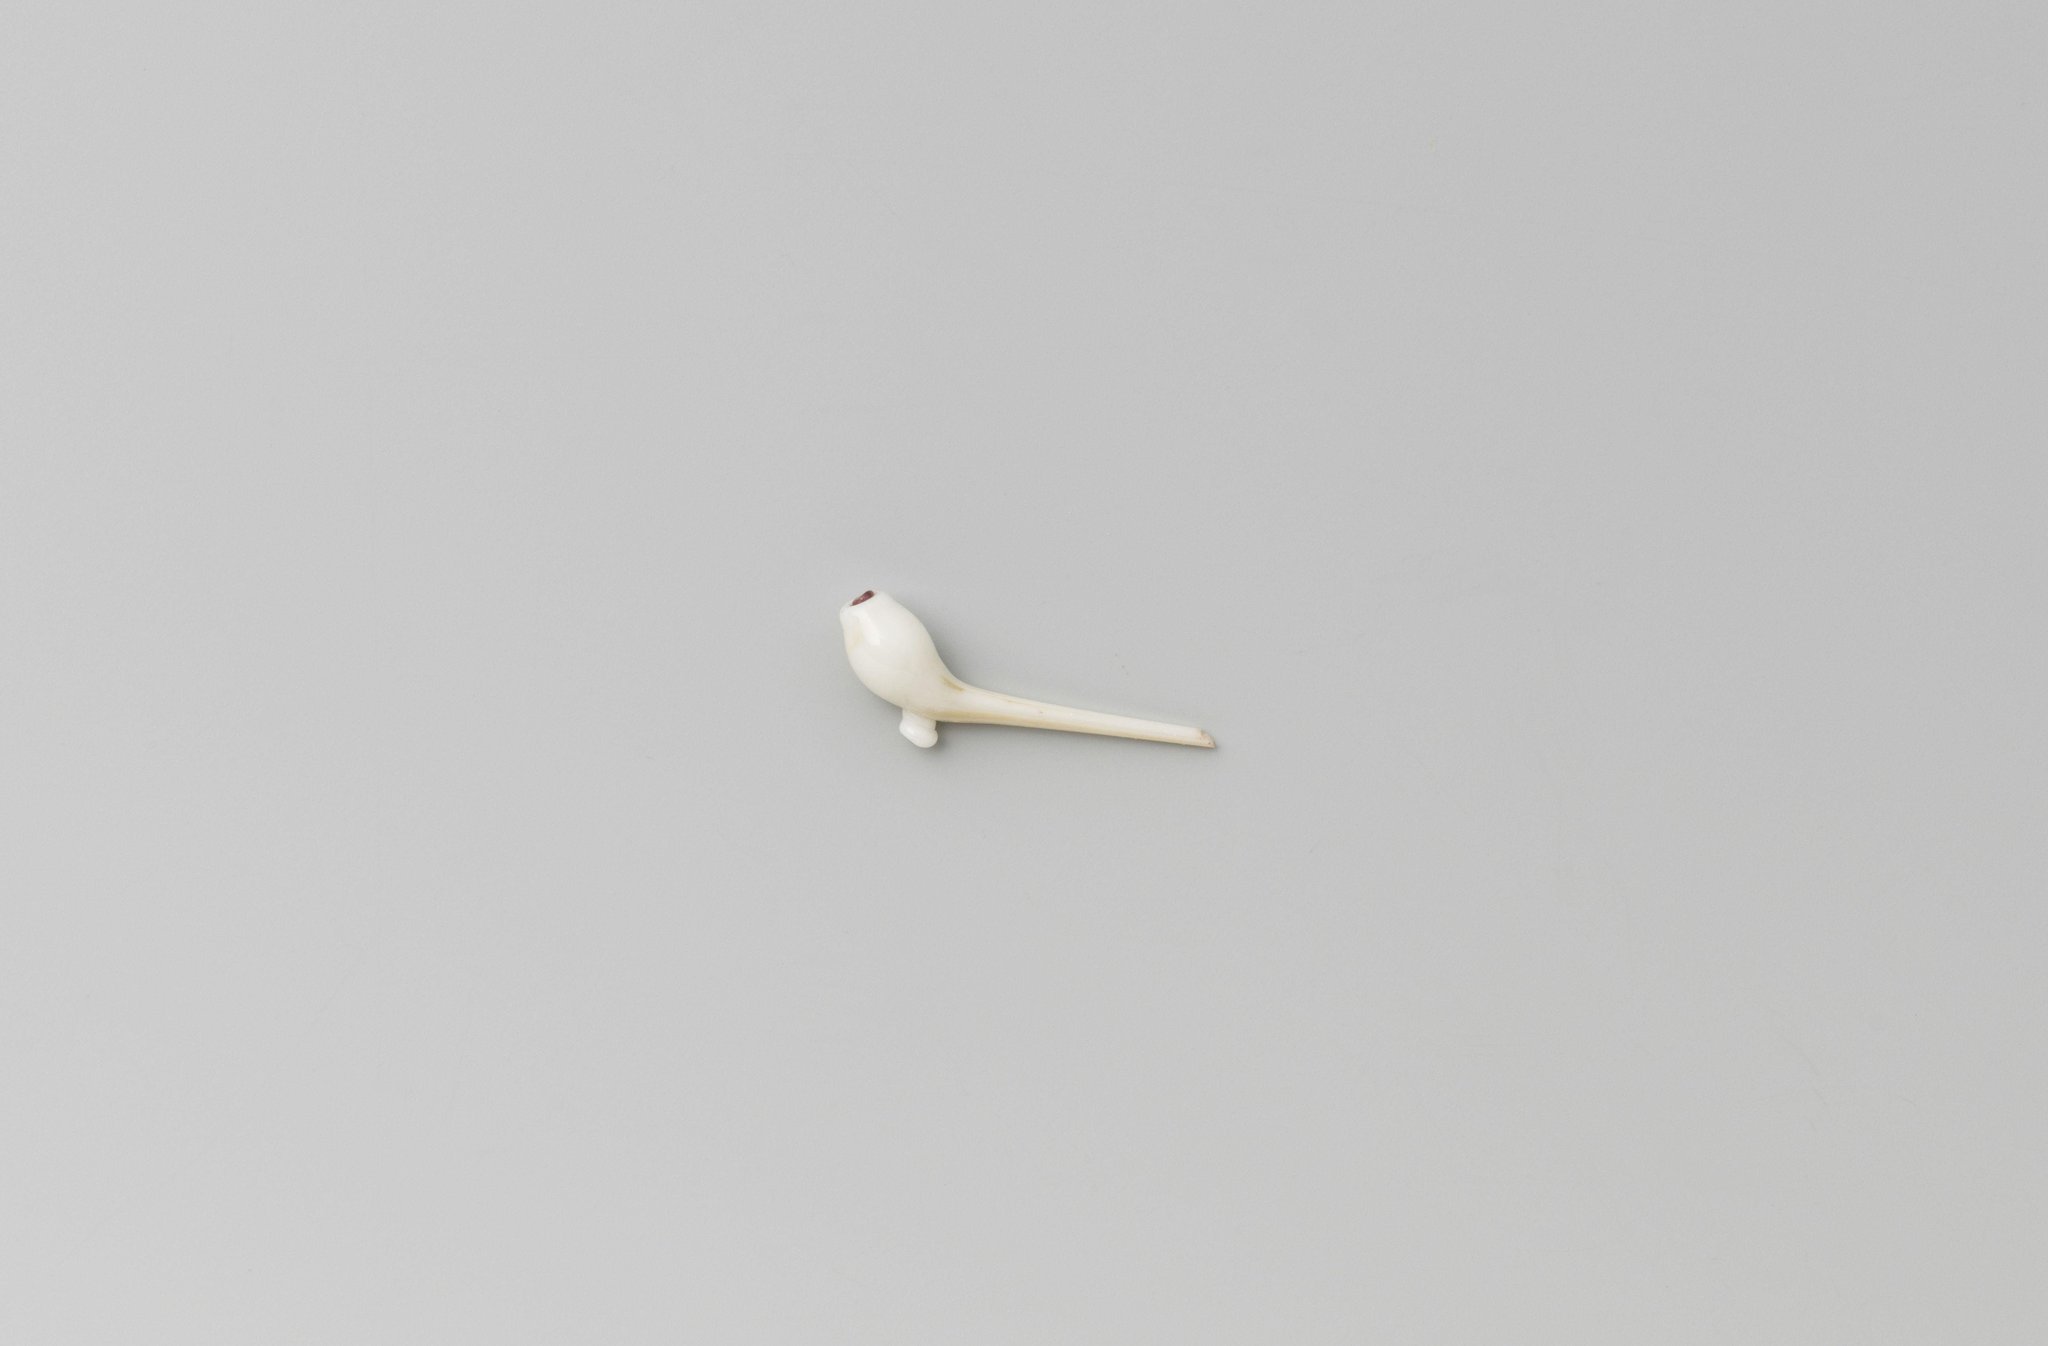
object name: miniature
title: Pijp van opaak wit glas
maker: Anonymous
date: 1675-1699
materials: glass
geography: amsterdam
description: Pijp van opaak wit glas, met holle steel en deels afgebroken kop met hiel.